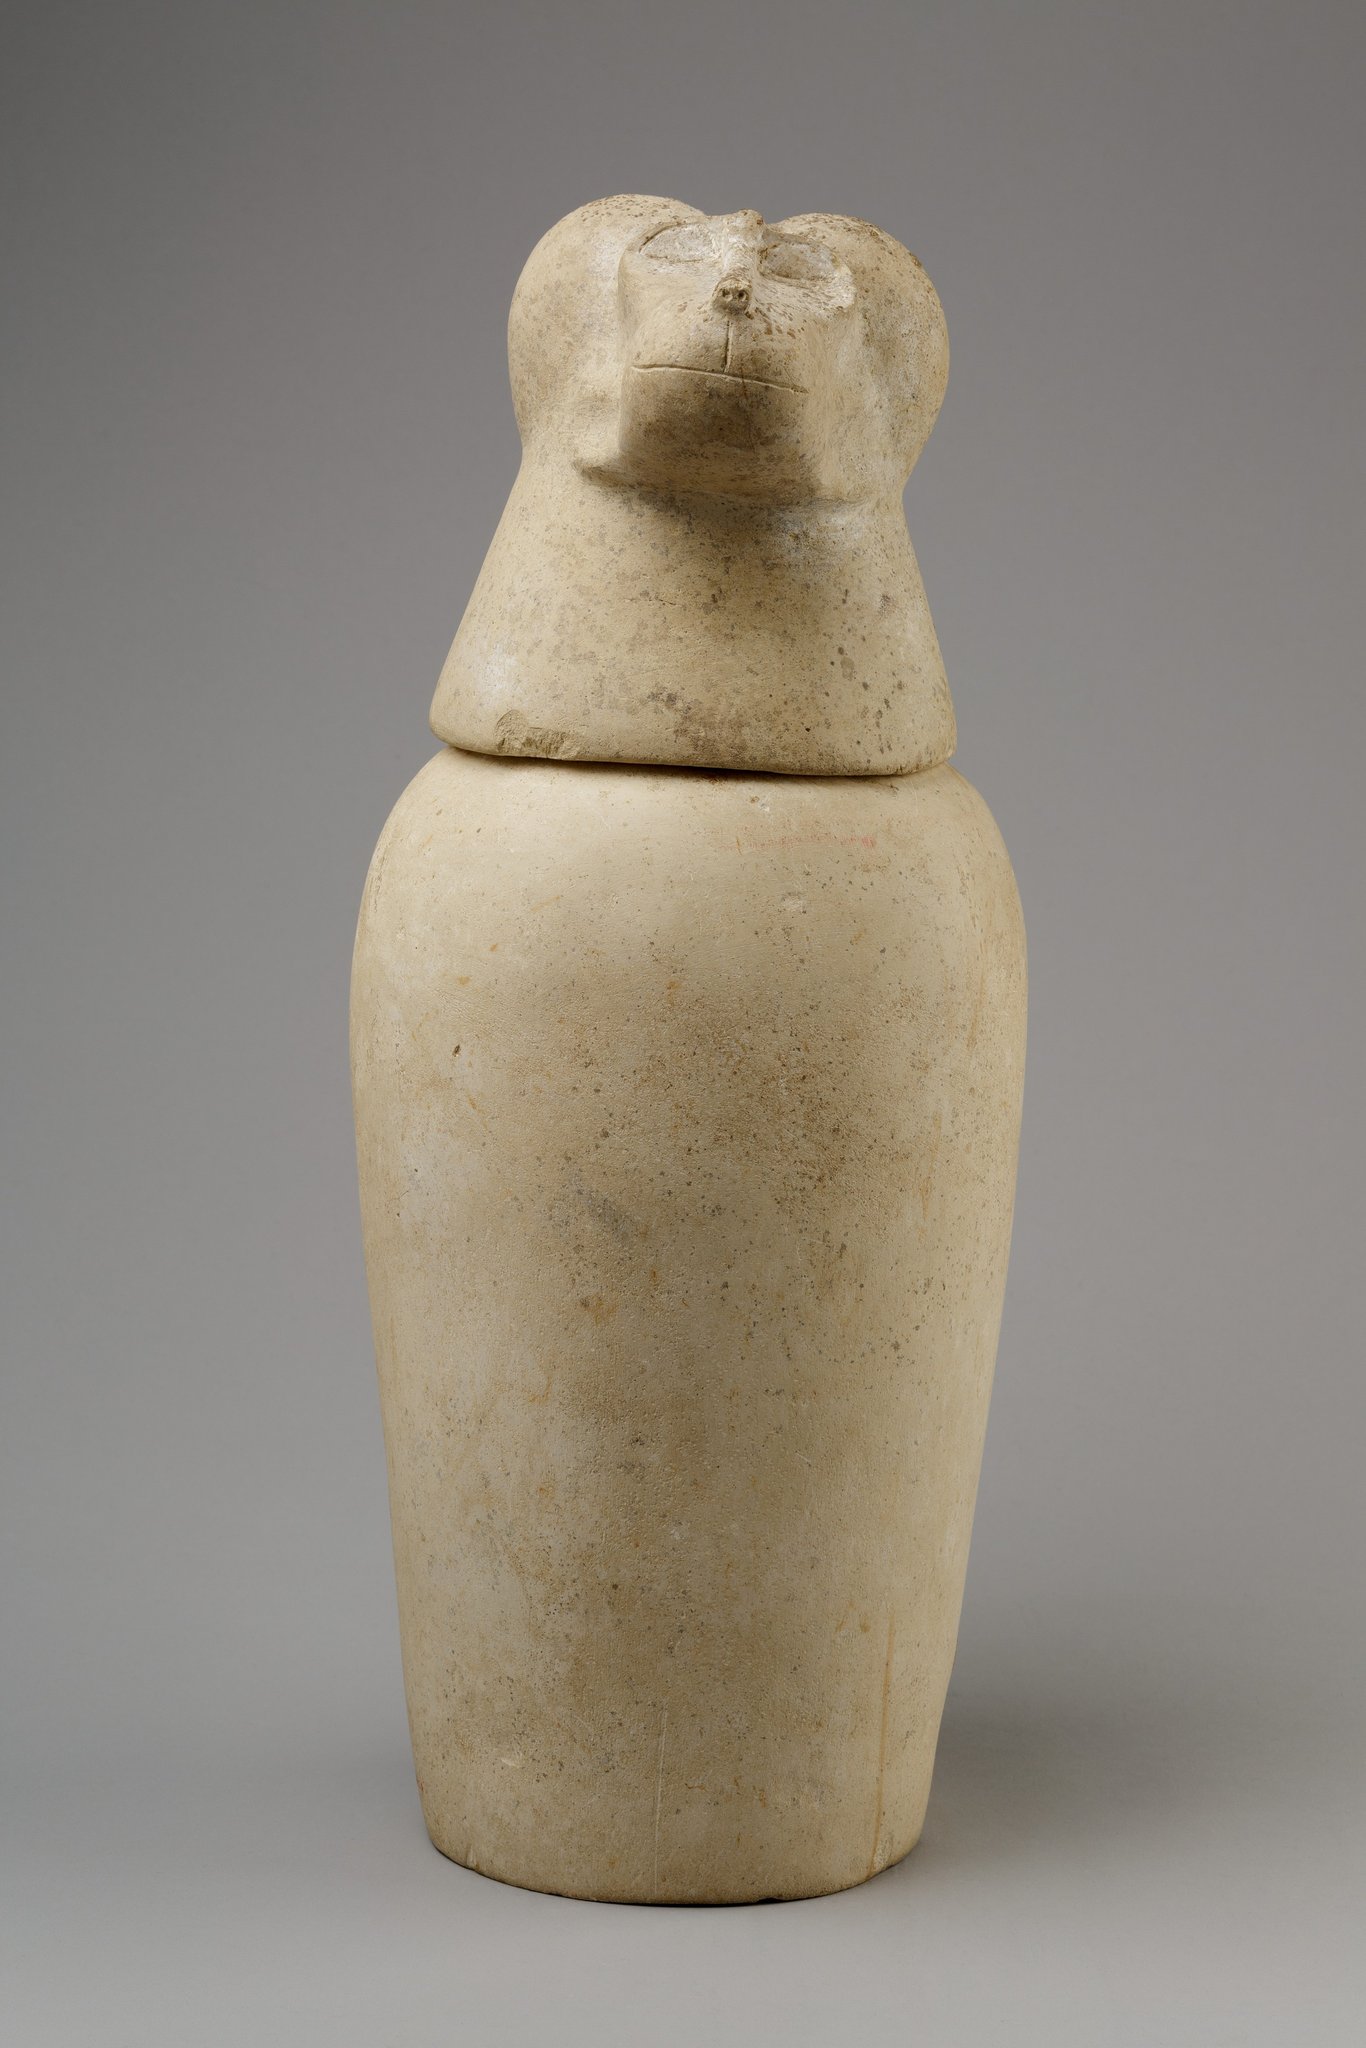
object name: canopic jar with head of baboon hapy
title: Canopic jar with head of baboon (Hapy)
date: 800-650 BCE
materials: limestone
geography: egypt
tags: baboons